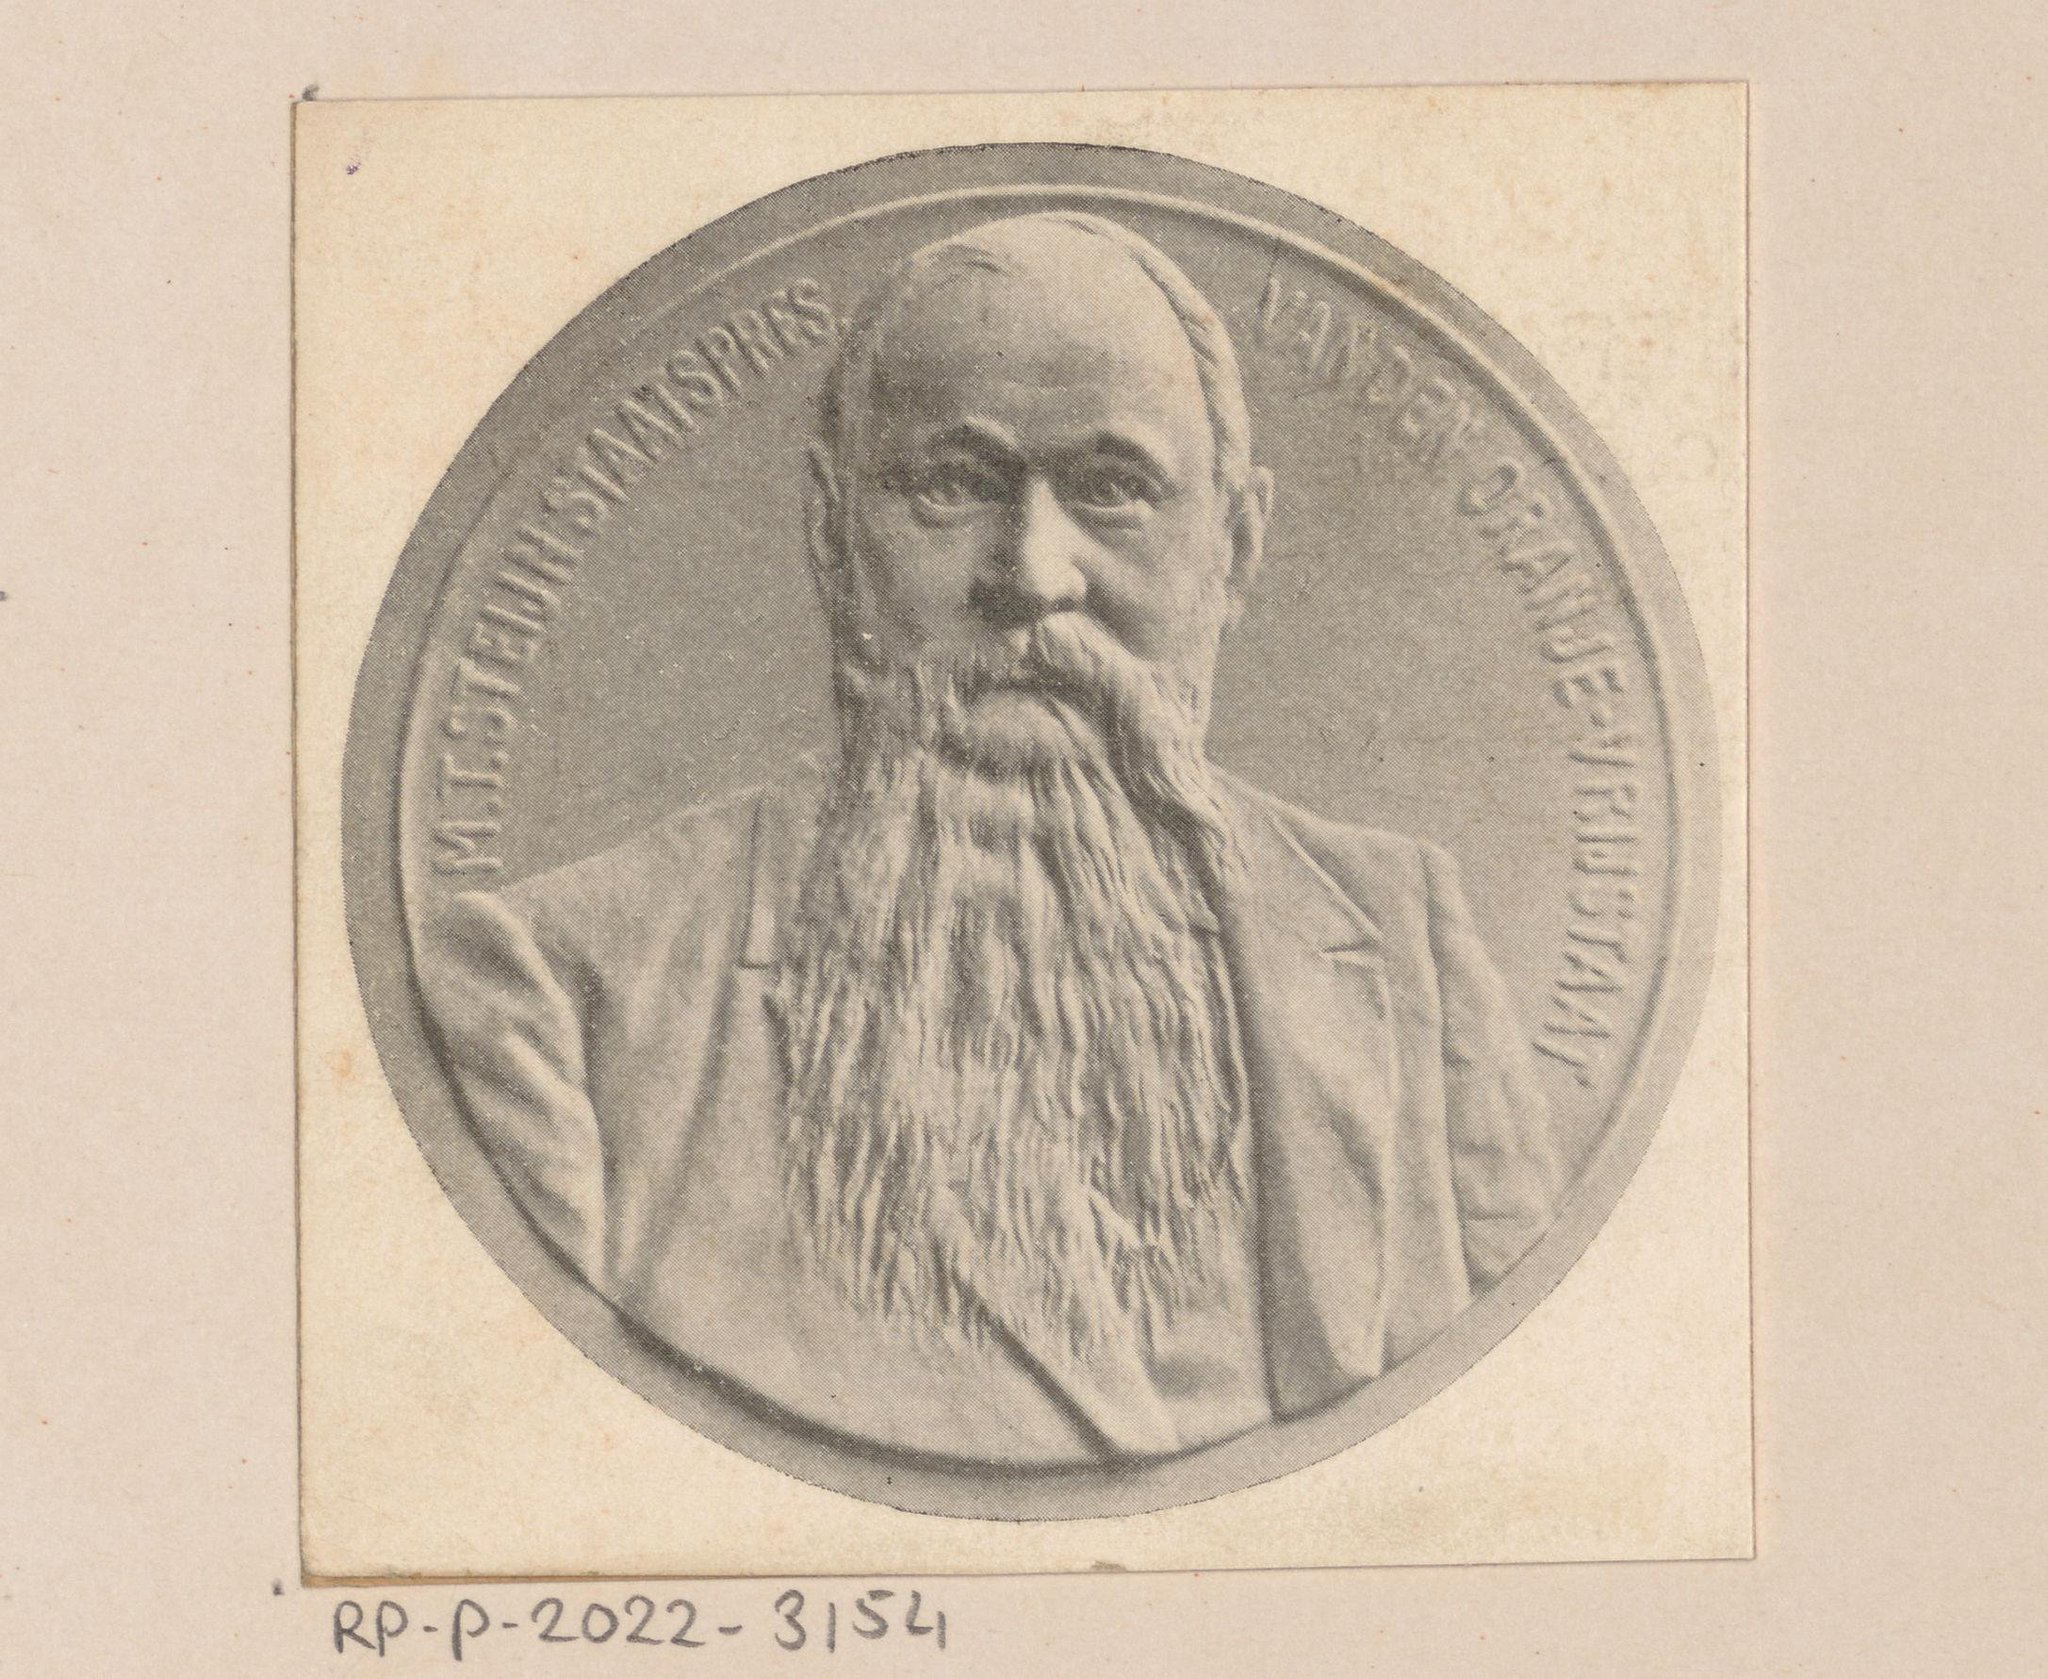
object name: photomechanical print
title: Portret van Martinus Theunis Steyn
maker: Anonymous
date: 1896-1970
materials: paper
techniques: autotype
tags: politician, president ~ head of republic, historical persons